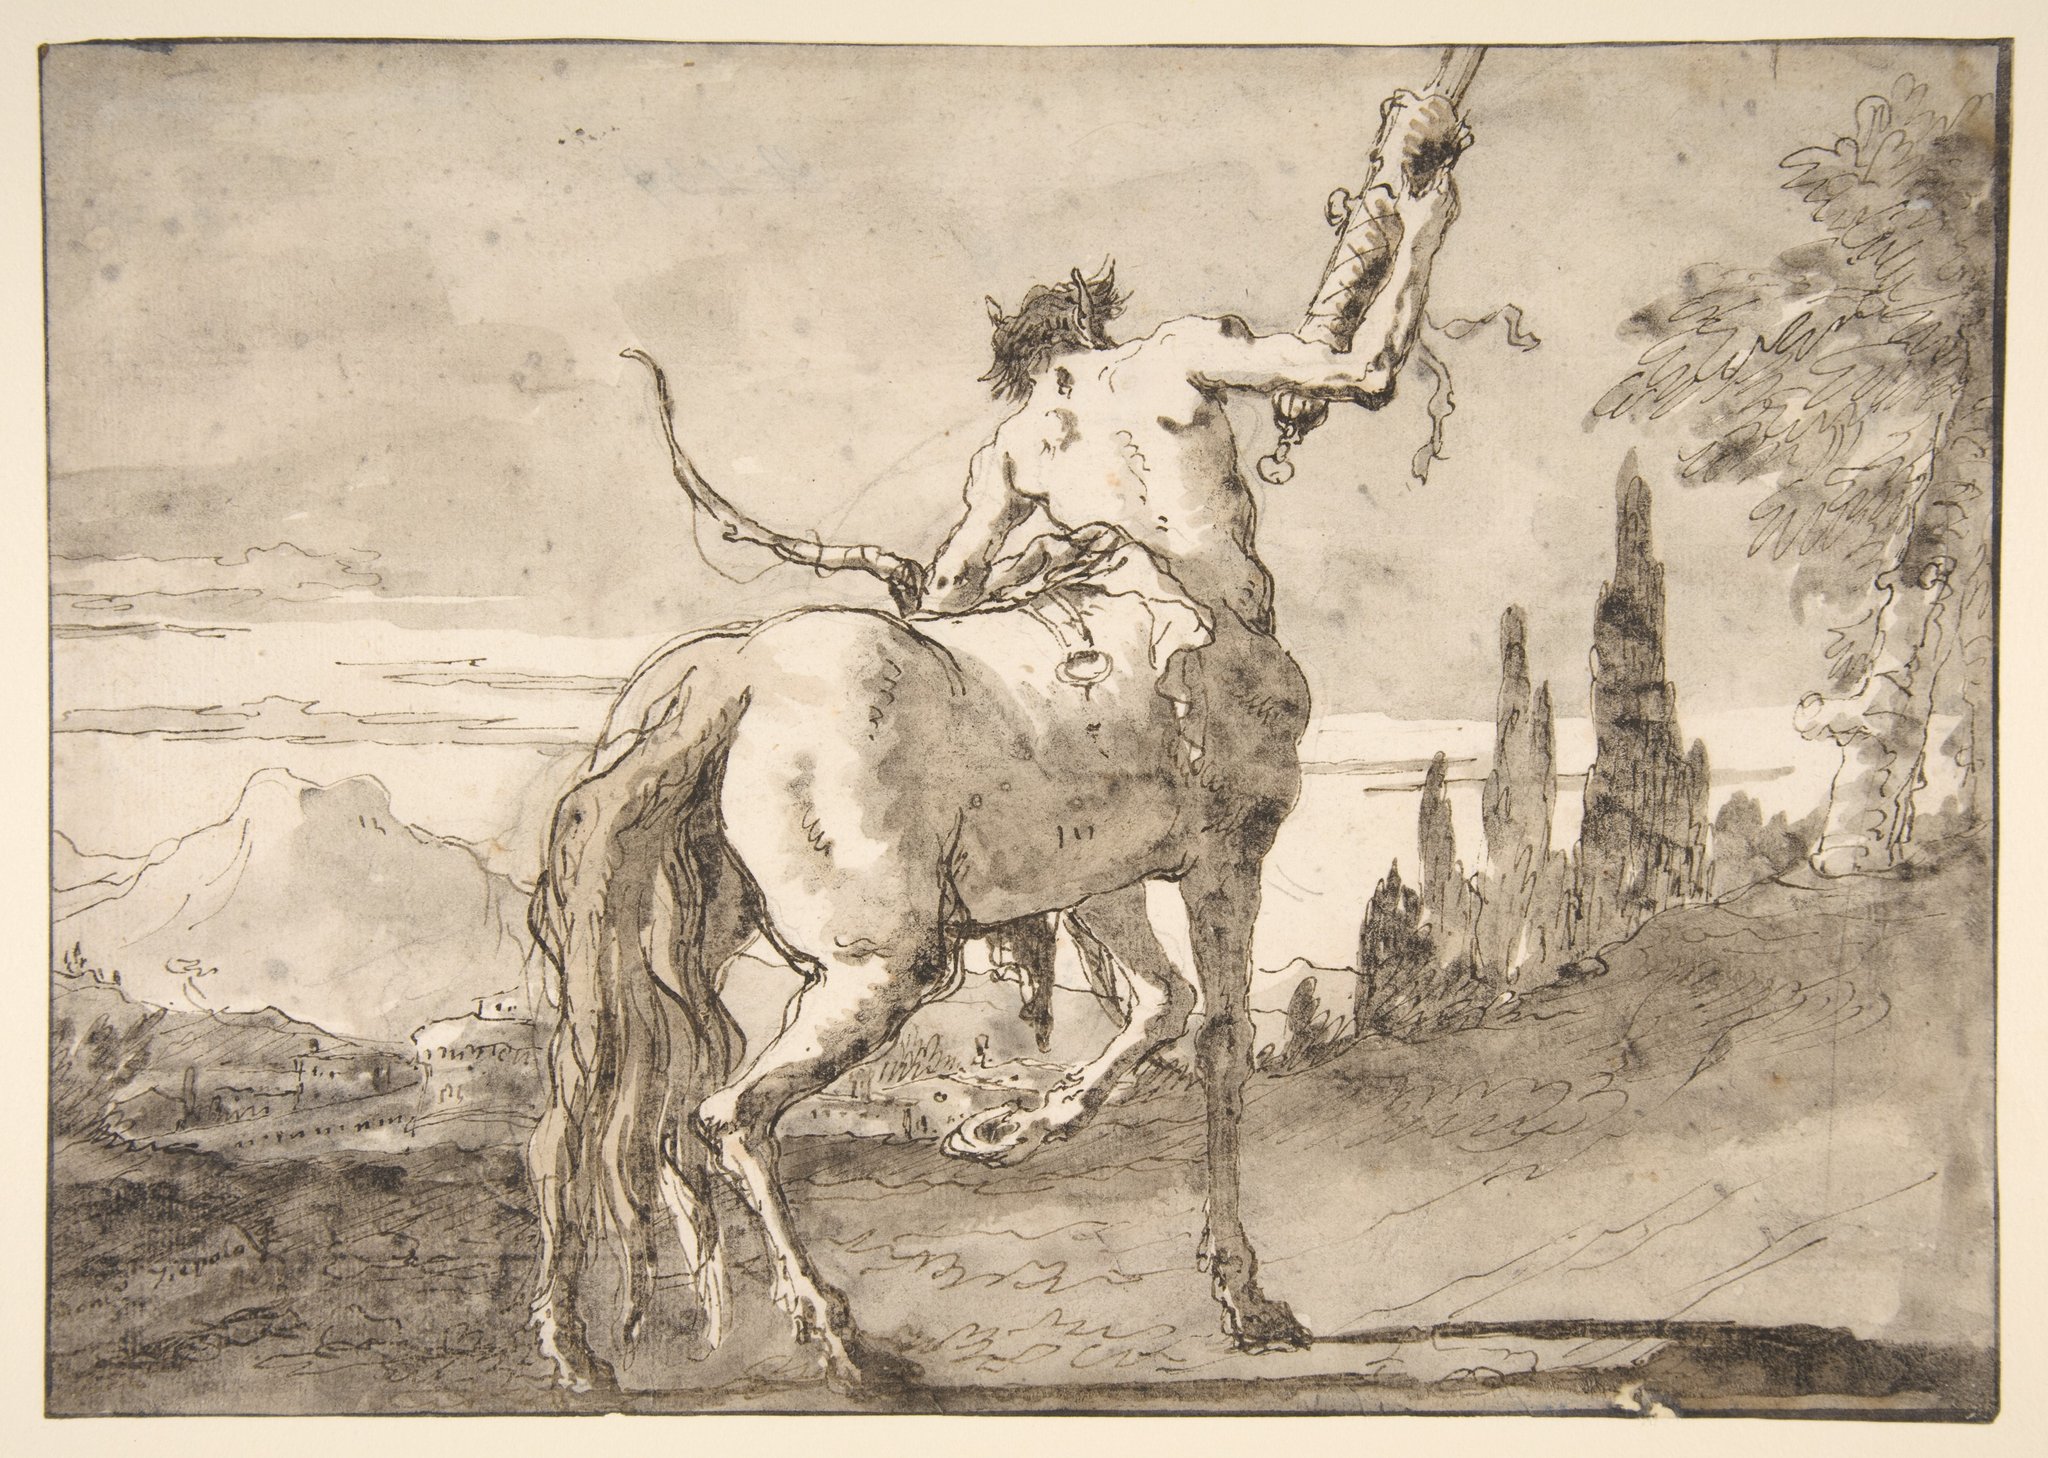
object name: drawing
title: Centaur Holding Up a Quiver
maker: giovanni domenico tiepolo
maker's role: artist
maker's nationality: italian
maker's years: 1727-1804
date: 1727-1804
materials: chalk, ink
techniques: brush, pen, wash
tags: bow and arrow,centaurs